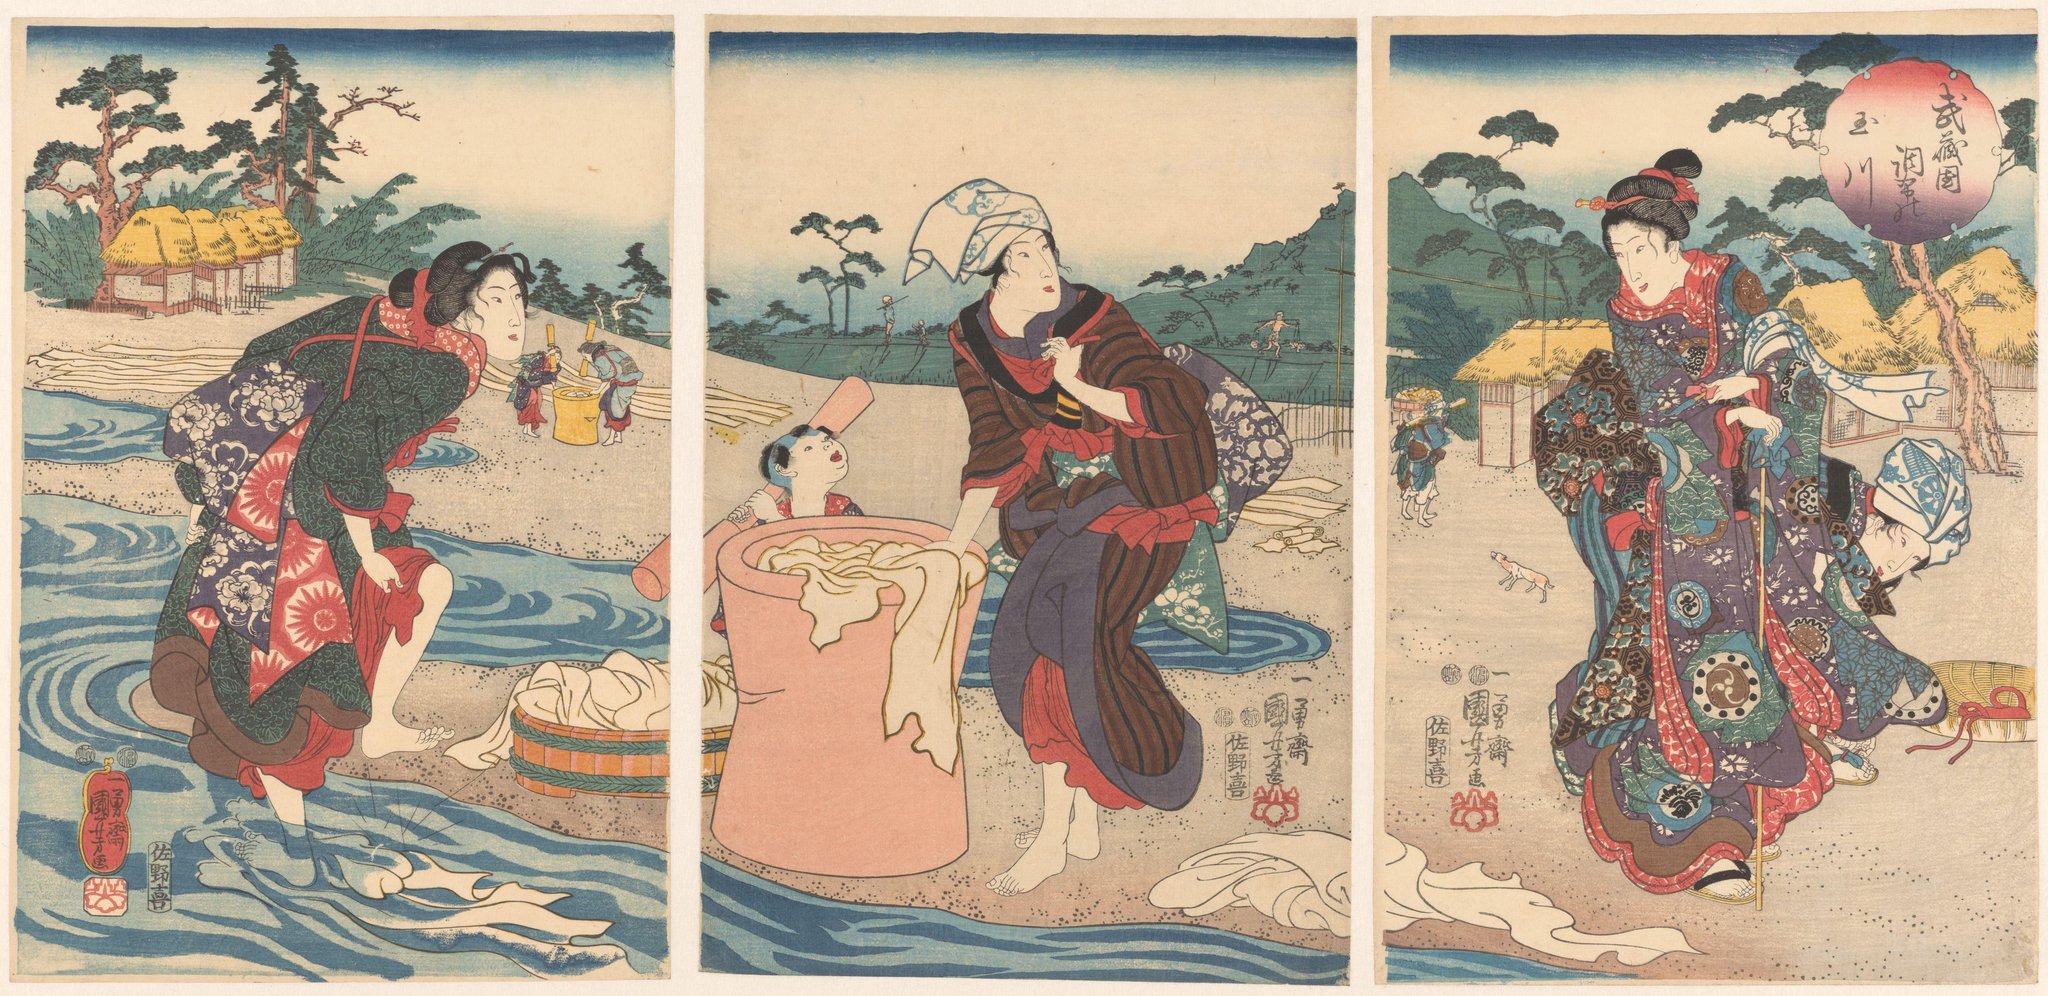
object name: triptych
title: De Chofu Tama rivier in de provincie Musashi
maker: utagawa kuniyoshi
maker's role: draughtsman, print maker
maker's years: 1798-1861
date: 1847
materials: paper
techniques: woodcut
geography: japan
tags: laundering, beach (+ landscape with figures, staffage)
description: Twee vrouwen en een kind witte doeken wassend in een rivier, terwijl een rijk geklede vrouw toekijkt. Op de achtergrond huizen en meer mensen bezig met verschillende fases van het wassen.